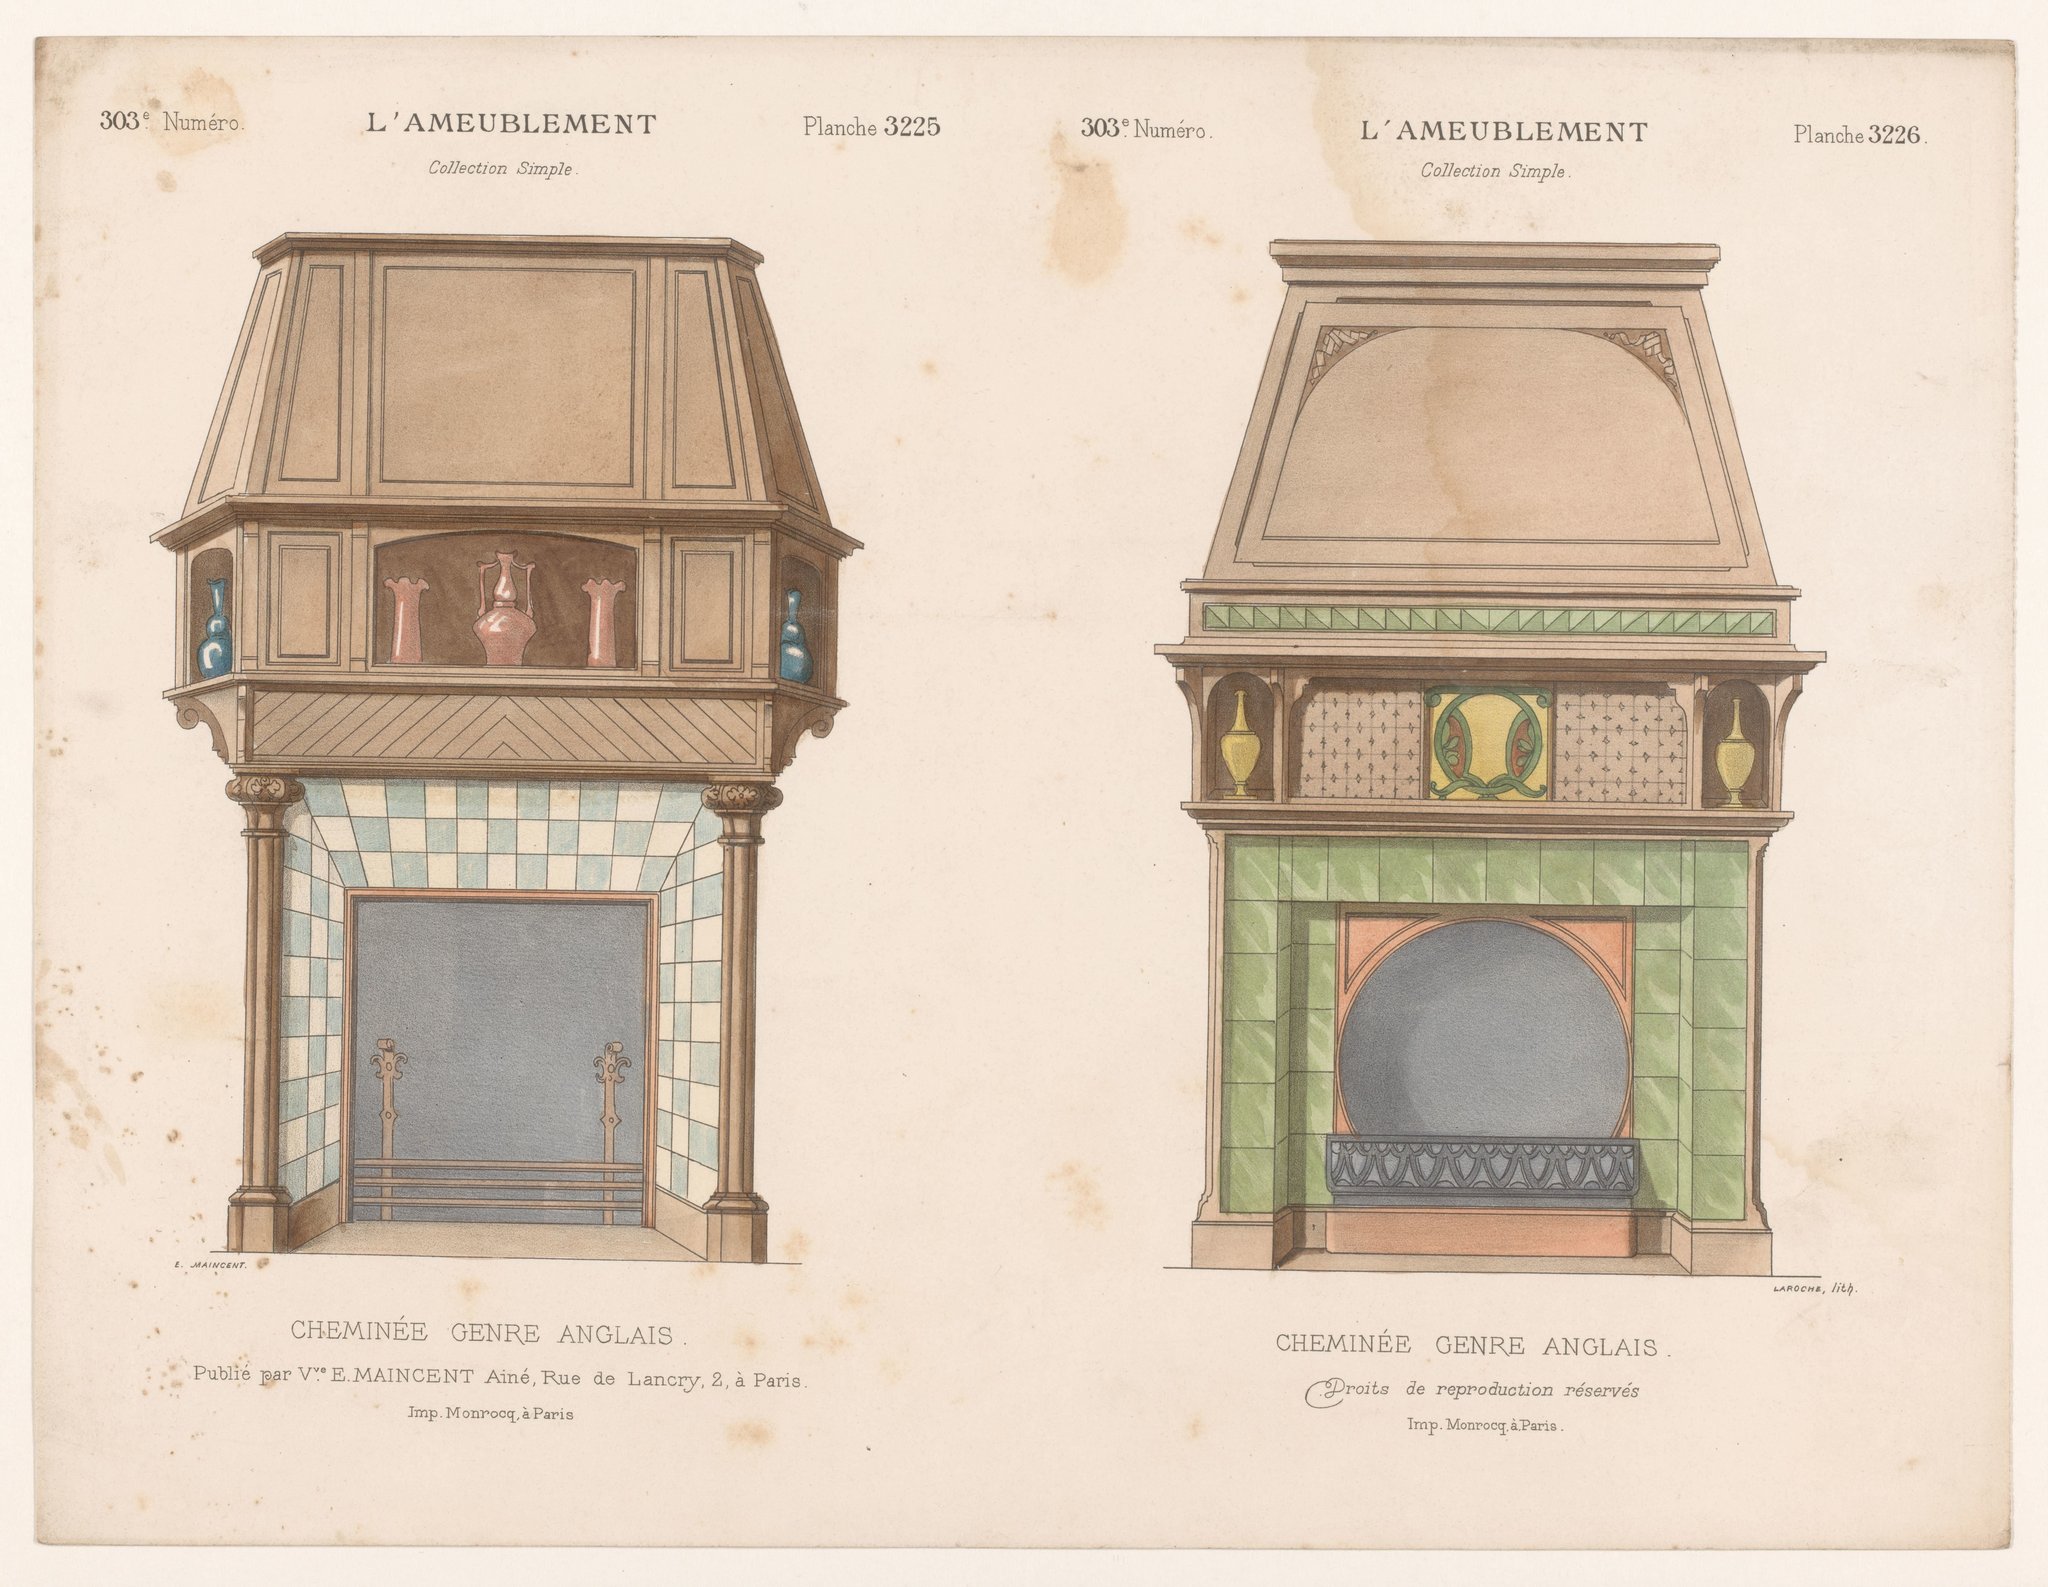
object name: print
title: Twee schouwen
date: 1895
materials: paper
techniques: hand coloring, lithograph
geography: paris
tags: chimney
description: Twee schouwen met vazen. Prent uit 303e nummer (livraison).